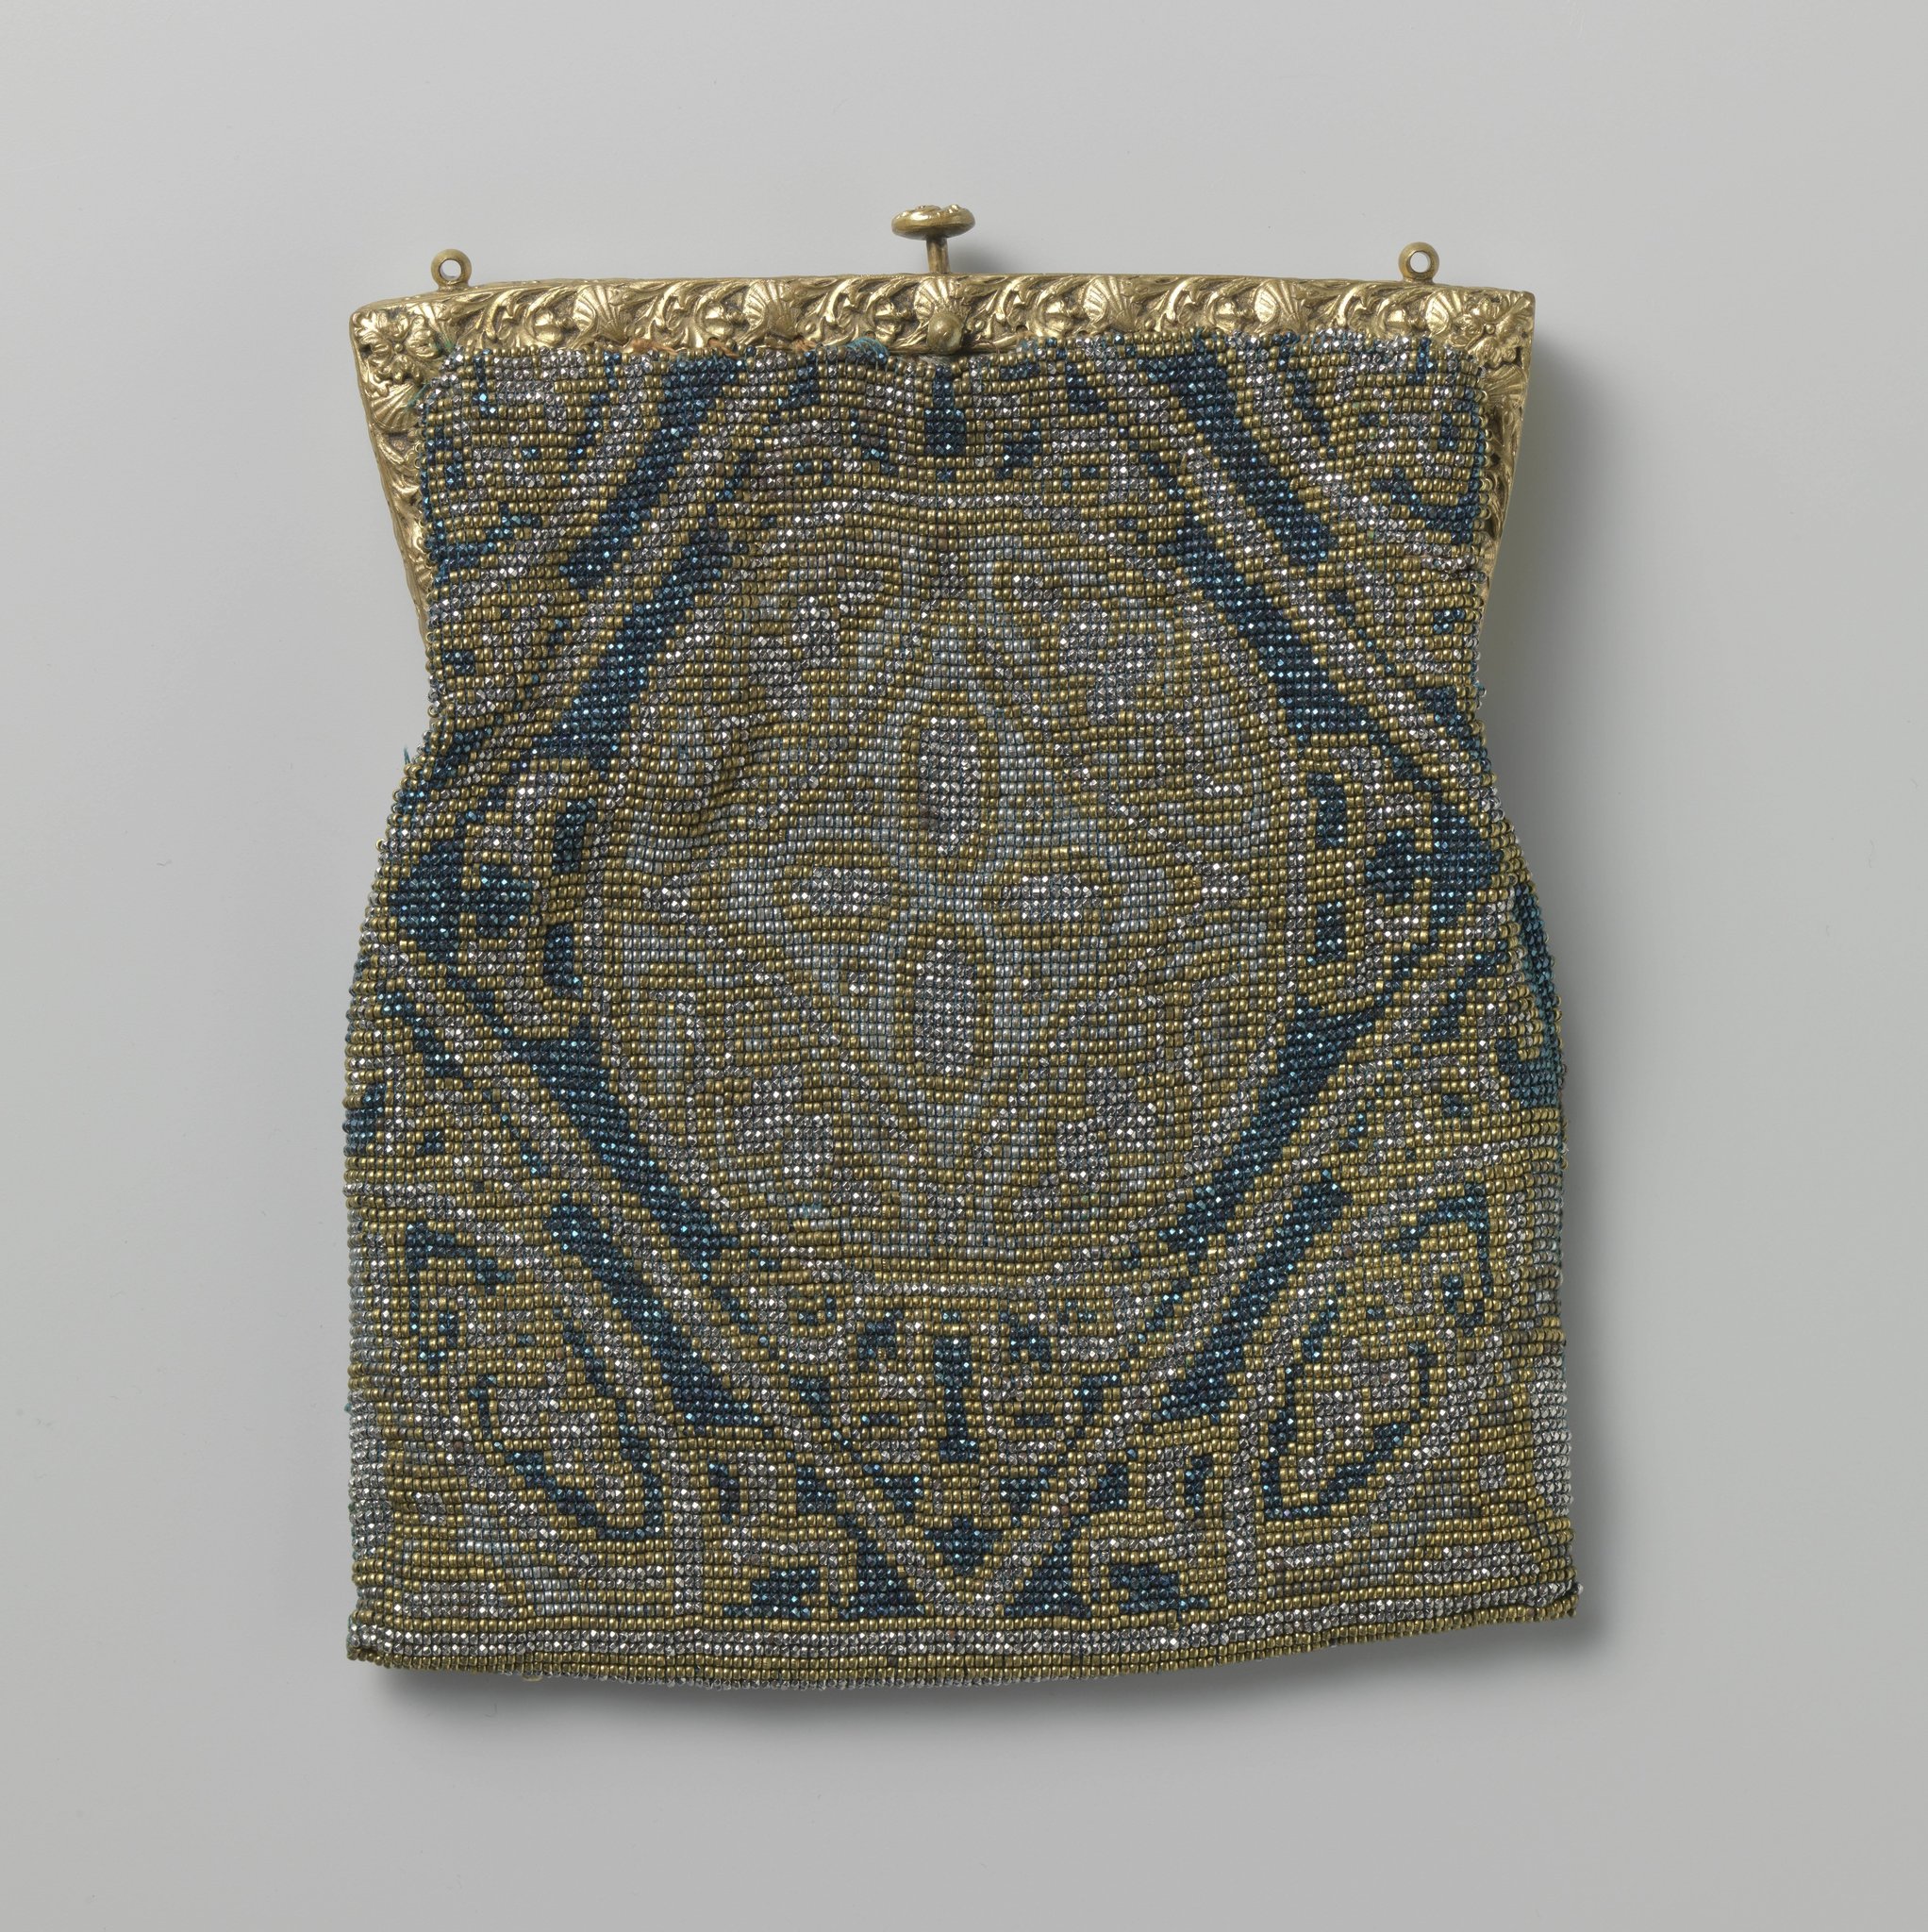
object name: kralentas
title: Tas in een plat, rechthoekig model, geheel van geslepen blauwe, goud- en zilverkleurige kralen in geometrisch patroon, met koperkleurige beugel in reliëf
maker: Anonymous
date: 1900-1920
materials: copper, silk, steel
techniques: forging, gilding, padding, weave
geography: netherlands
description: Tas in een plat, rechthoekig model, geheel van geslepen blauwe, goud- en zilverkleurige kralen in symmetrisch en geometrisch patroon dat aan de voor- en achterkant gelijk is. De rechthoekige koperkleurige beugel heeft een schelpen en bladeren reliëf en opent met een drukknop. Bovenop twee koperen ogen, mogelijk voor een hengsel. De binnenkant bestaat uit een grijskleurige gewatteerde in diagonale gestikte voering.